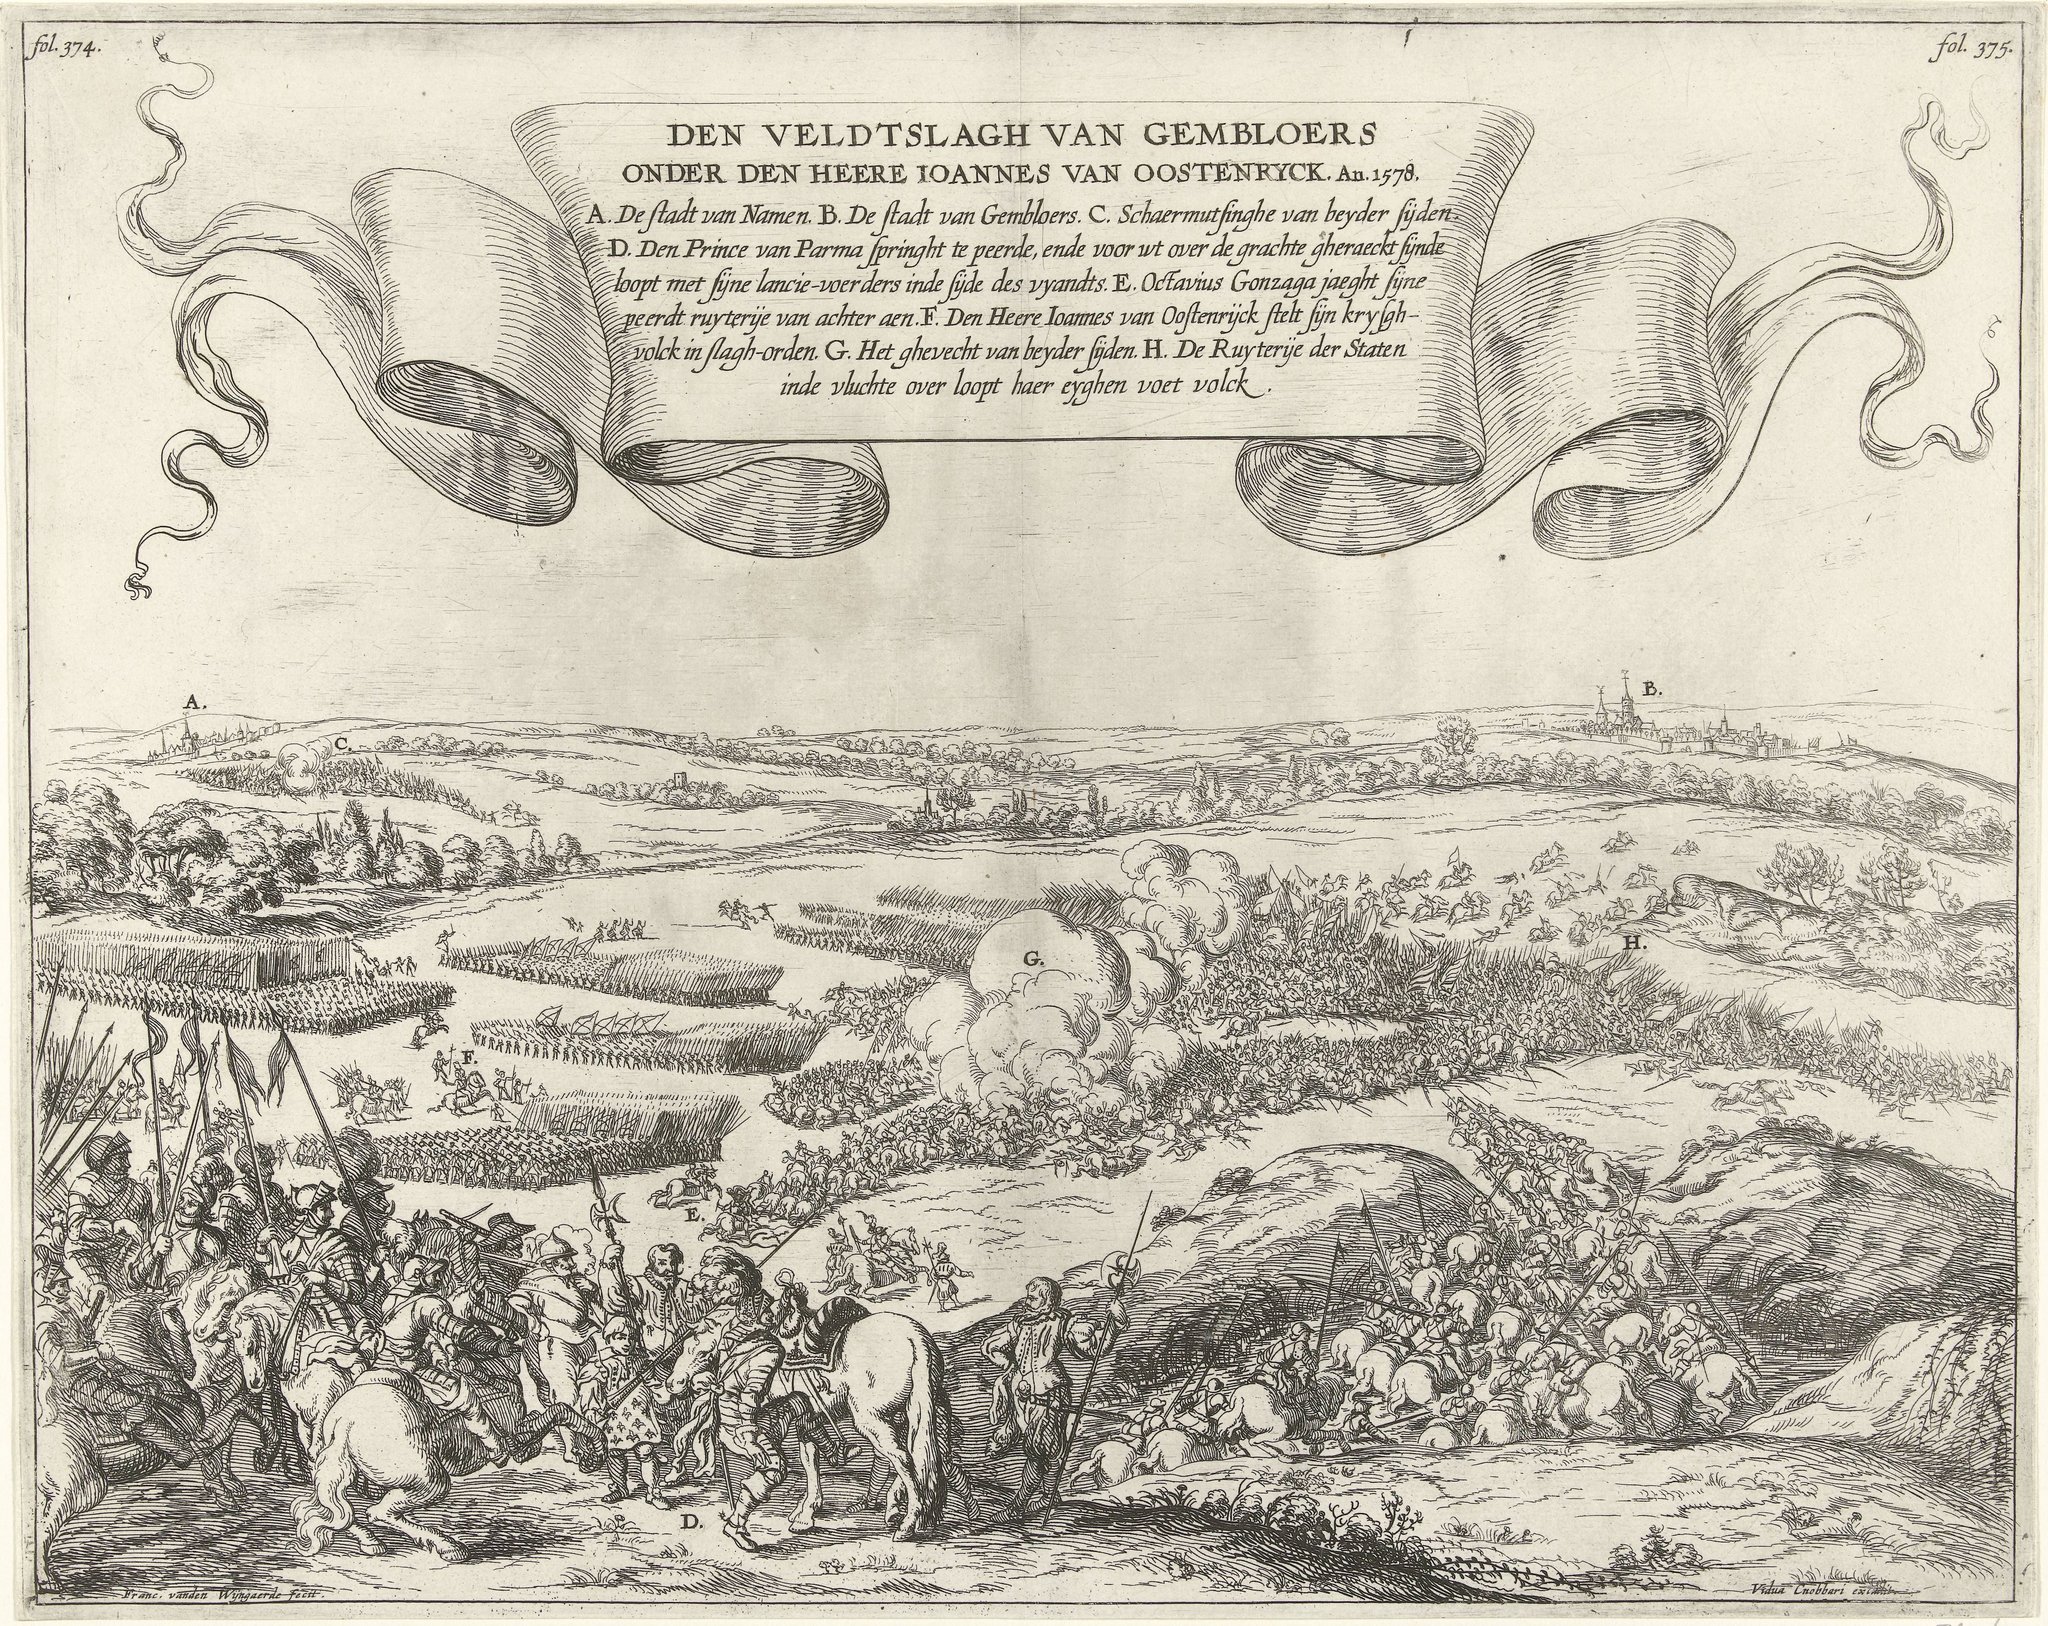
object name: history print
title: Den veldtslagh van Gembloers onder den heere Ioannes van Oostenryck, An. 1578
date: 1643-1645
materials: paper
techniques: etching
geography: southern netherlands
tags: battle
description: Slag bij Gembloers, 31 januari 1578. Veldslag waarbij het Staatse leger verslagen wordt door het leger van Farnese. In de verte de steden Namen en Gembloux. Bovenin een banderol met de titel en legenda A-H in het Nederlands.